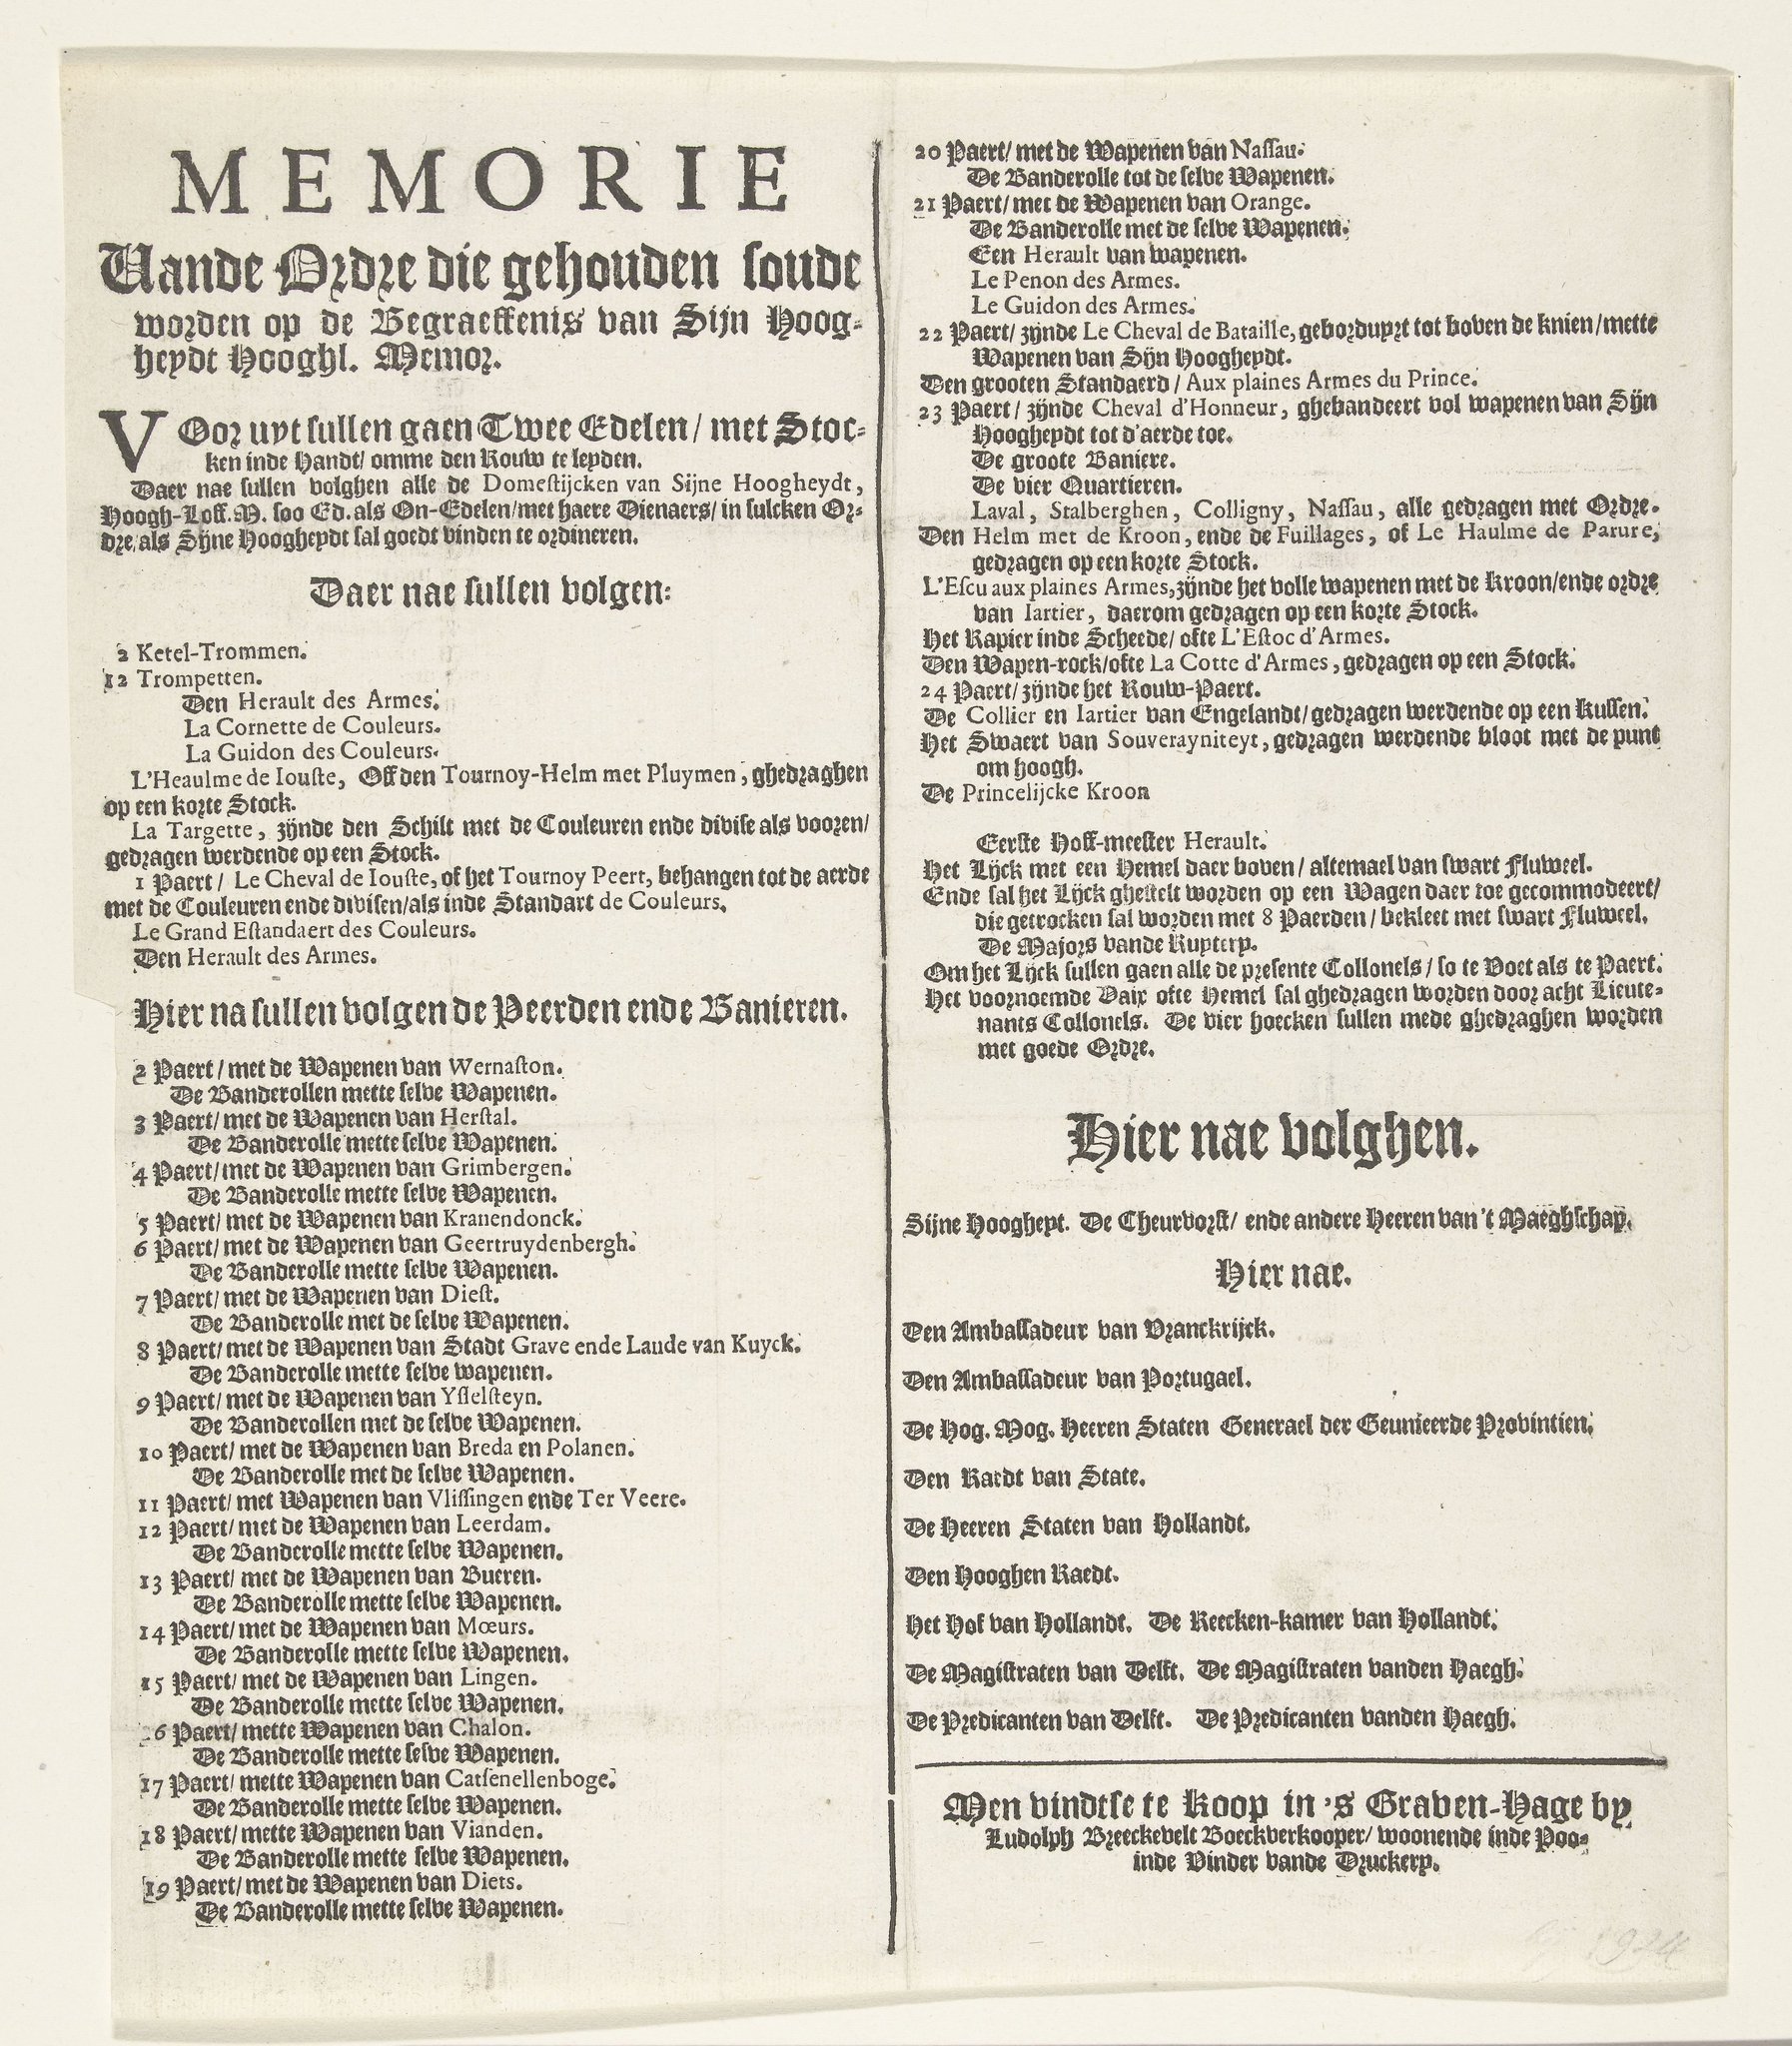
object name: programma, programmaboekje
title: Memorie vande Ordre die gehouden soude worden op de Begraeffenis van Sijn Hoogheydt Hooghl. Memor.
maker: ludolph breeckevelt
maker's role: publisher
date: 1647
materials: paper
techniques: letterpress printing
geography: the hague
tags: frederick henry (prince of orange)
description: Blad met een gedrukte tekst in twee kolommen met een gedetailleerde beschrijving van de lijkstatie van Frederik Hendrik die op 10 mei 1647 te 's-Gravenhage gehouden zal worden. Exemplaar van de druk zonder het jaartal.